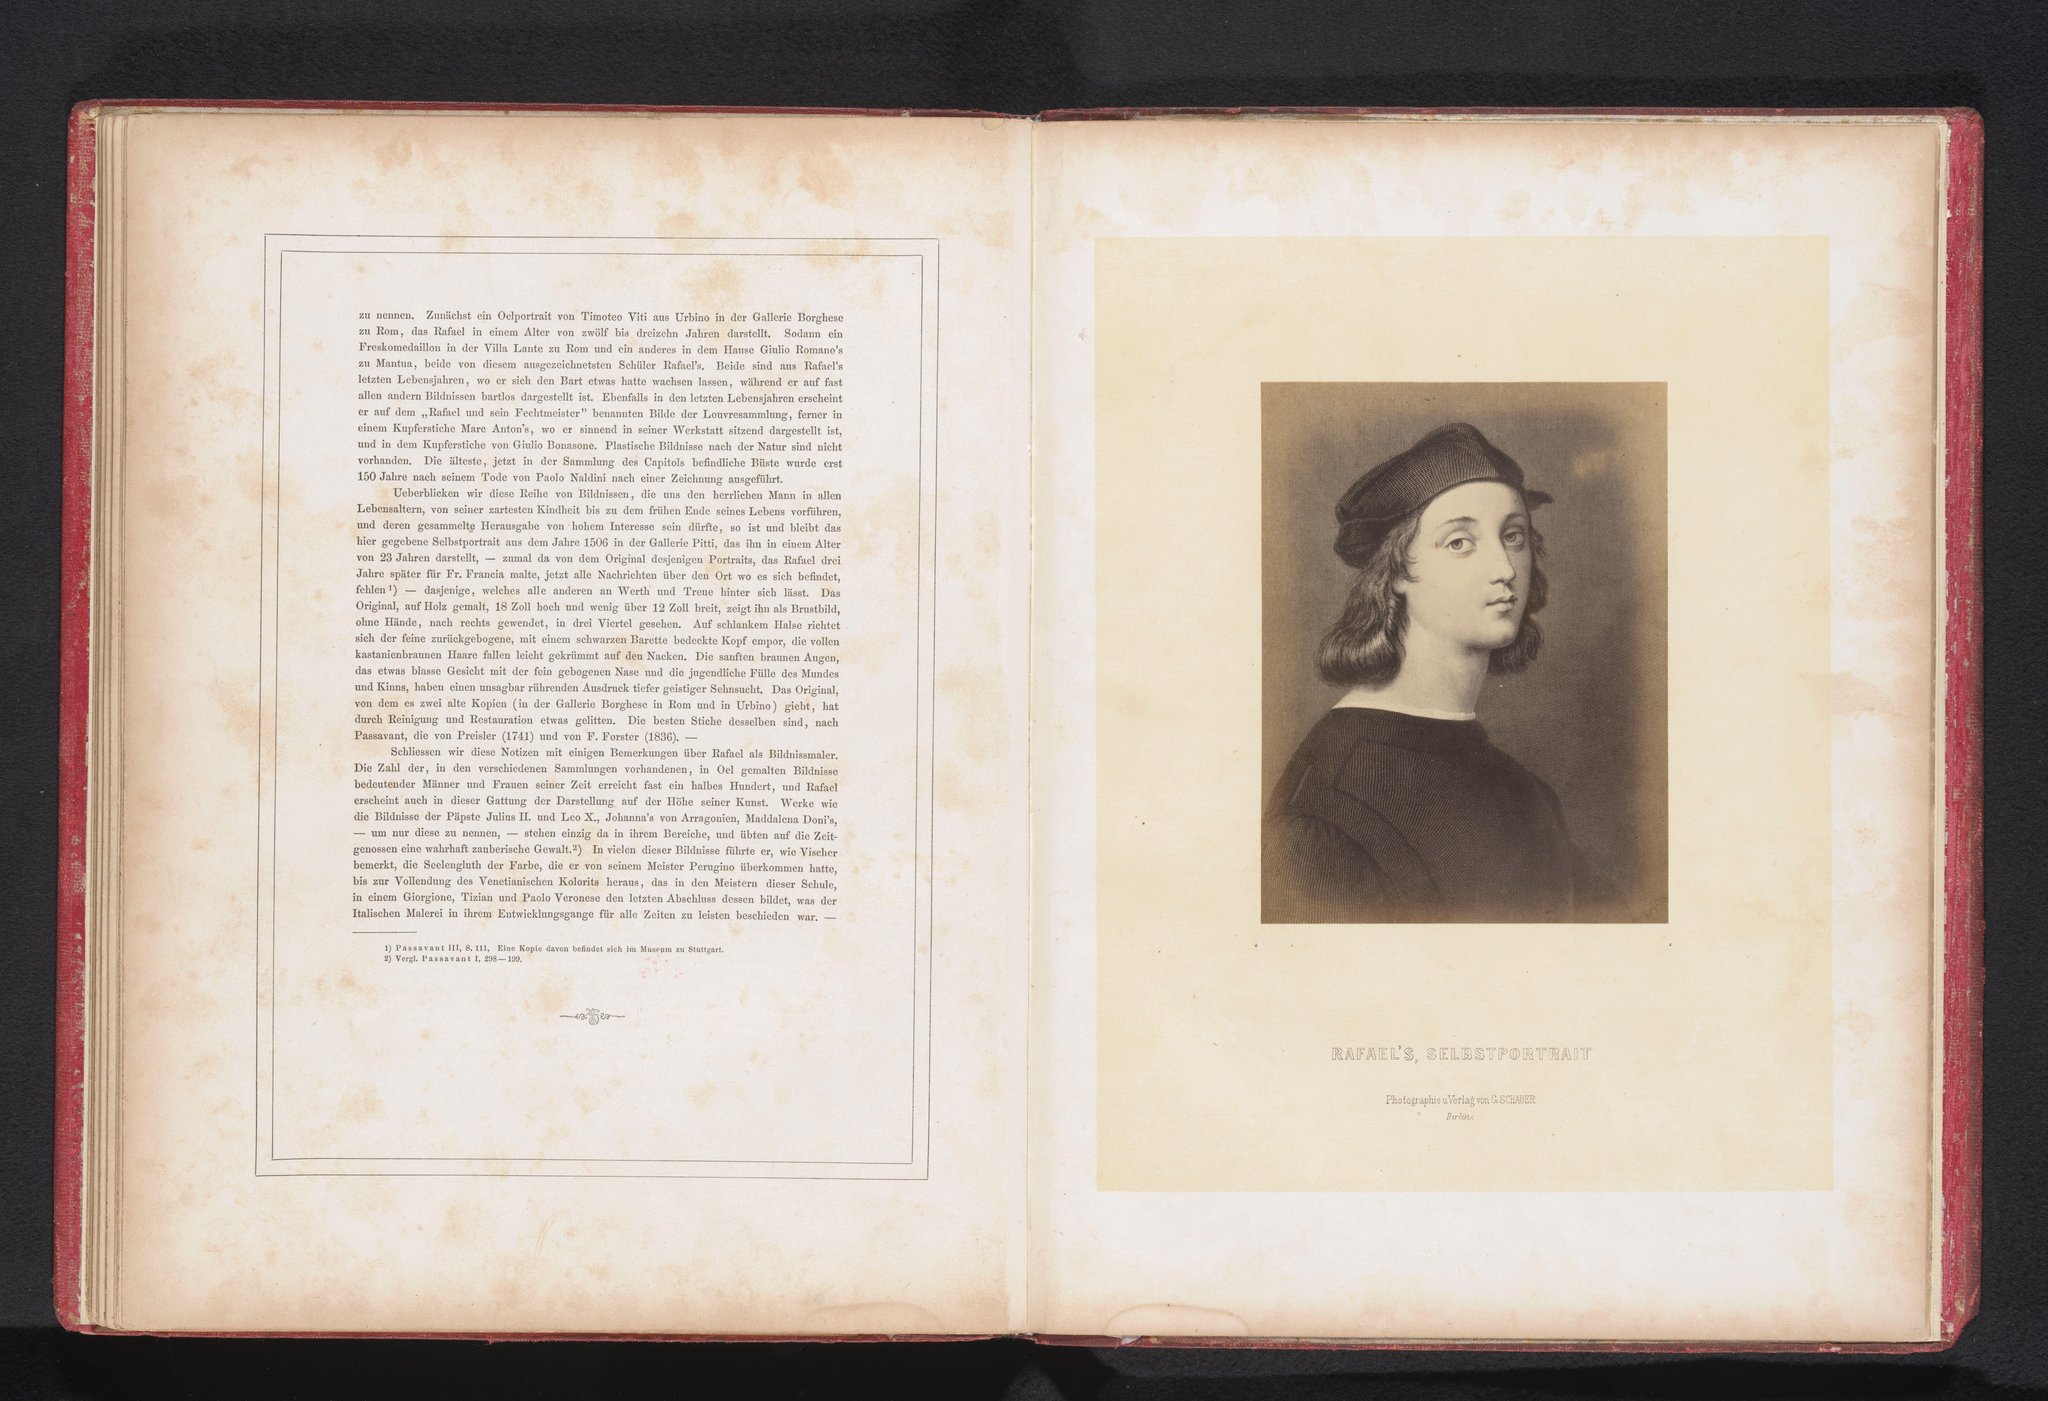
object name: photograph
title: Rafael's selbstportrait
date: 1851-1861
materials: photographic support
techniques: albumen print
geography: berlin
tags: portrait, self-portrait of painter